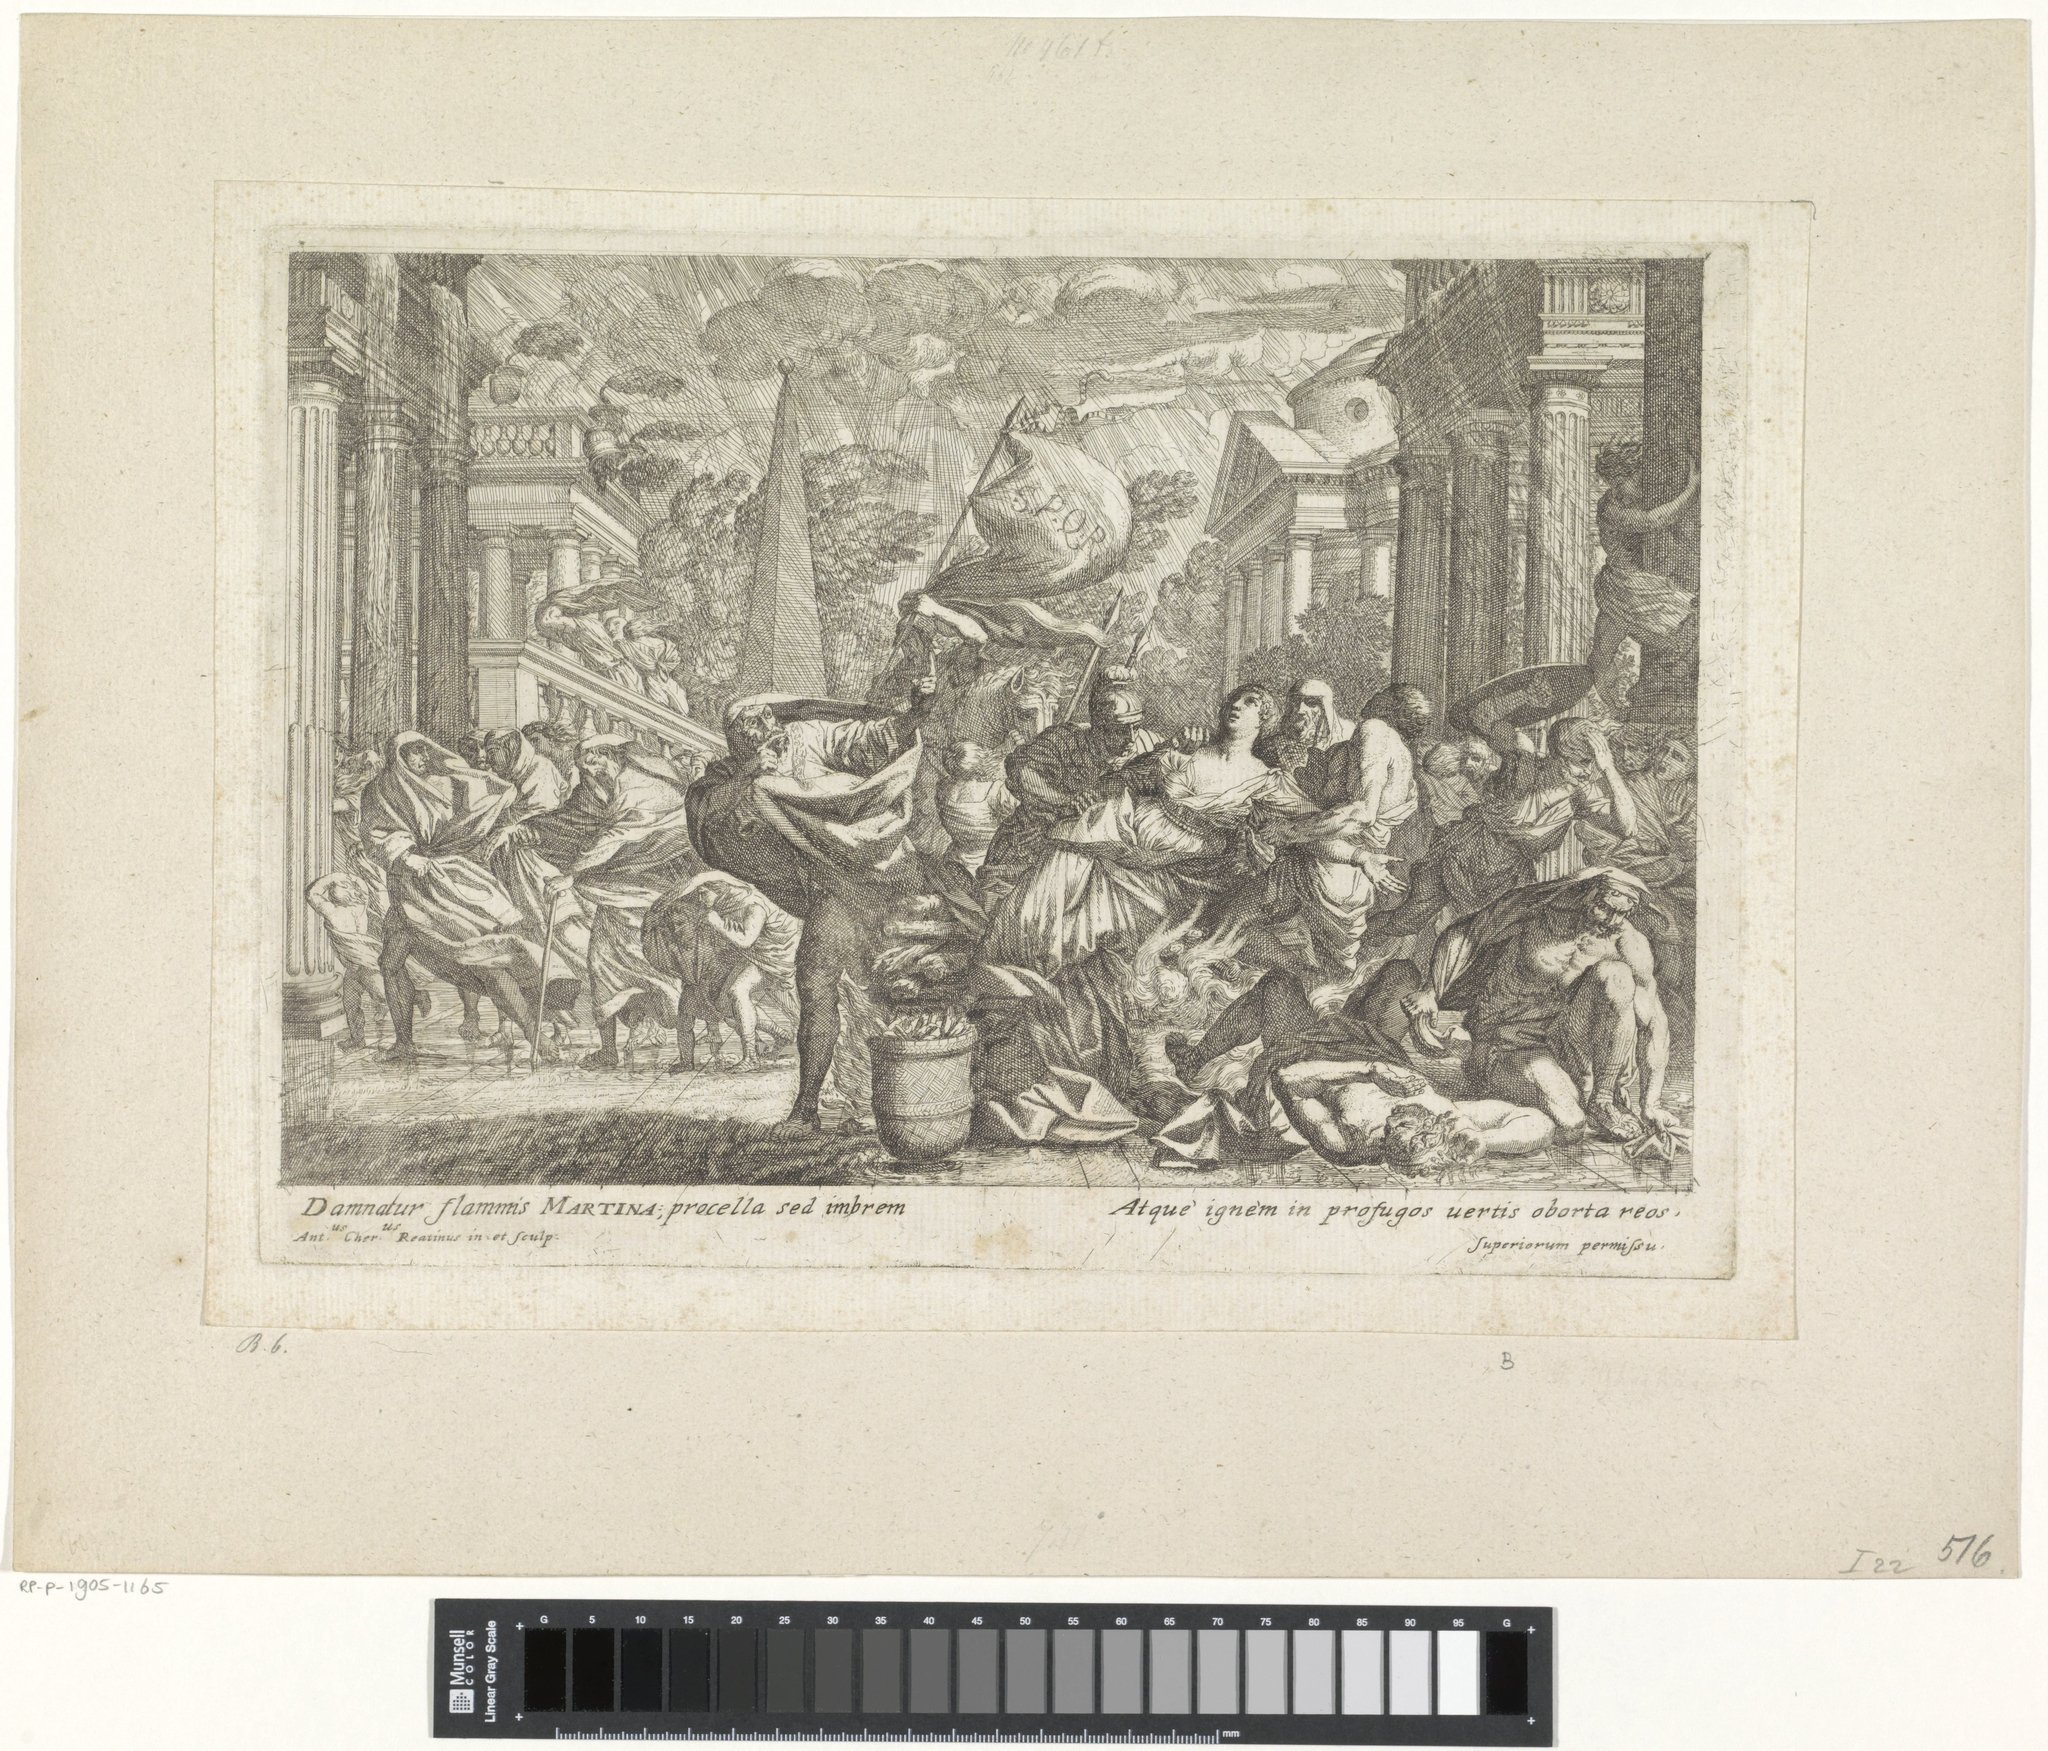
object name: print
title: De heilige Martina op de brandstapel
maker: antonio gherardi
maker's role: print maker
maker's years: 1644-1702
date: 1654-1702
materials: paper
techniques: etching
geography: italy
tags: violent death by burning at the stake; pyre, female saints (martina of rome) - martyrdom, suffering, misfortune, death of female saint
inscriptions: collector's mark: Lugt 2228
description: De heilige Martina op de brandstapel. De vlammen van de brandstapel vallen op haar martelaars die proberen te schuilen. Centraal een man met een vlag met daarop: S.P.Q.R..